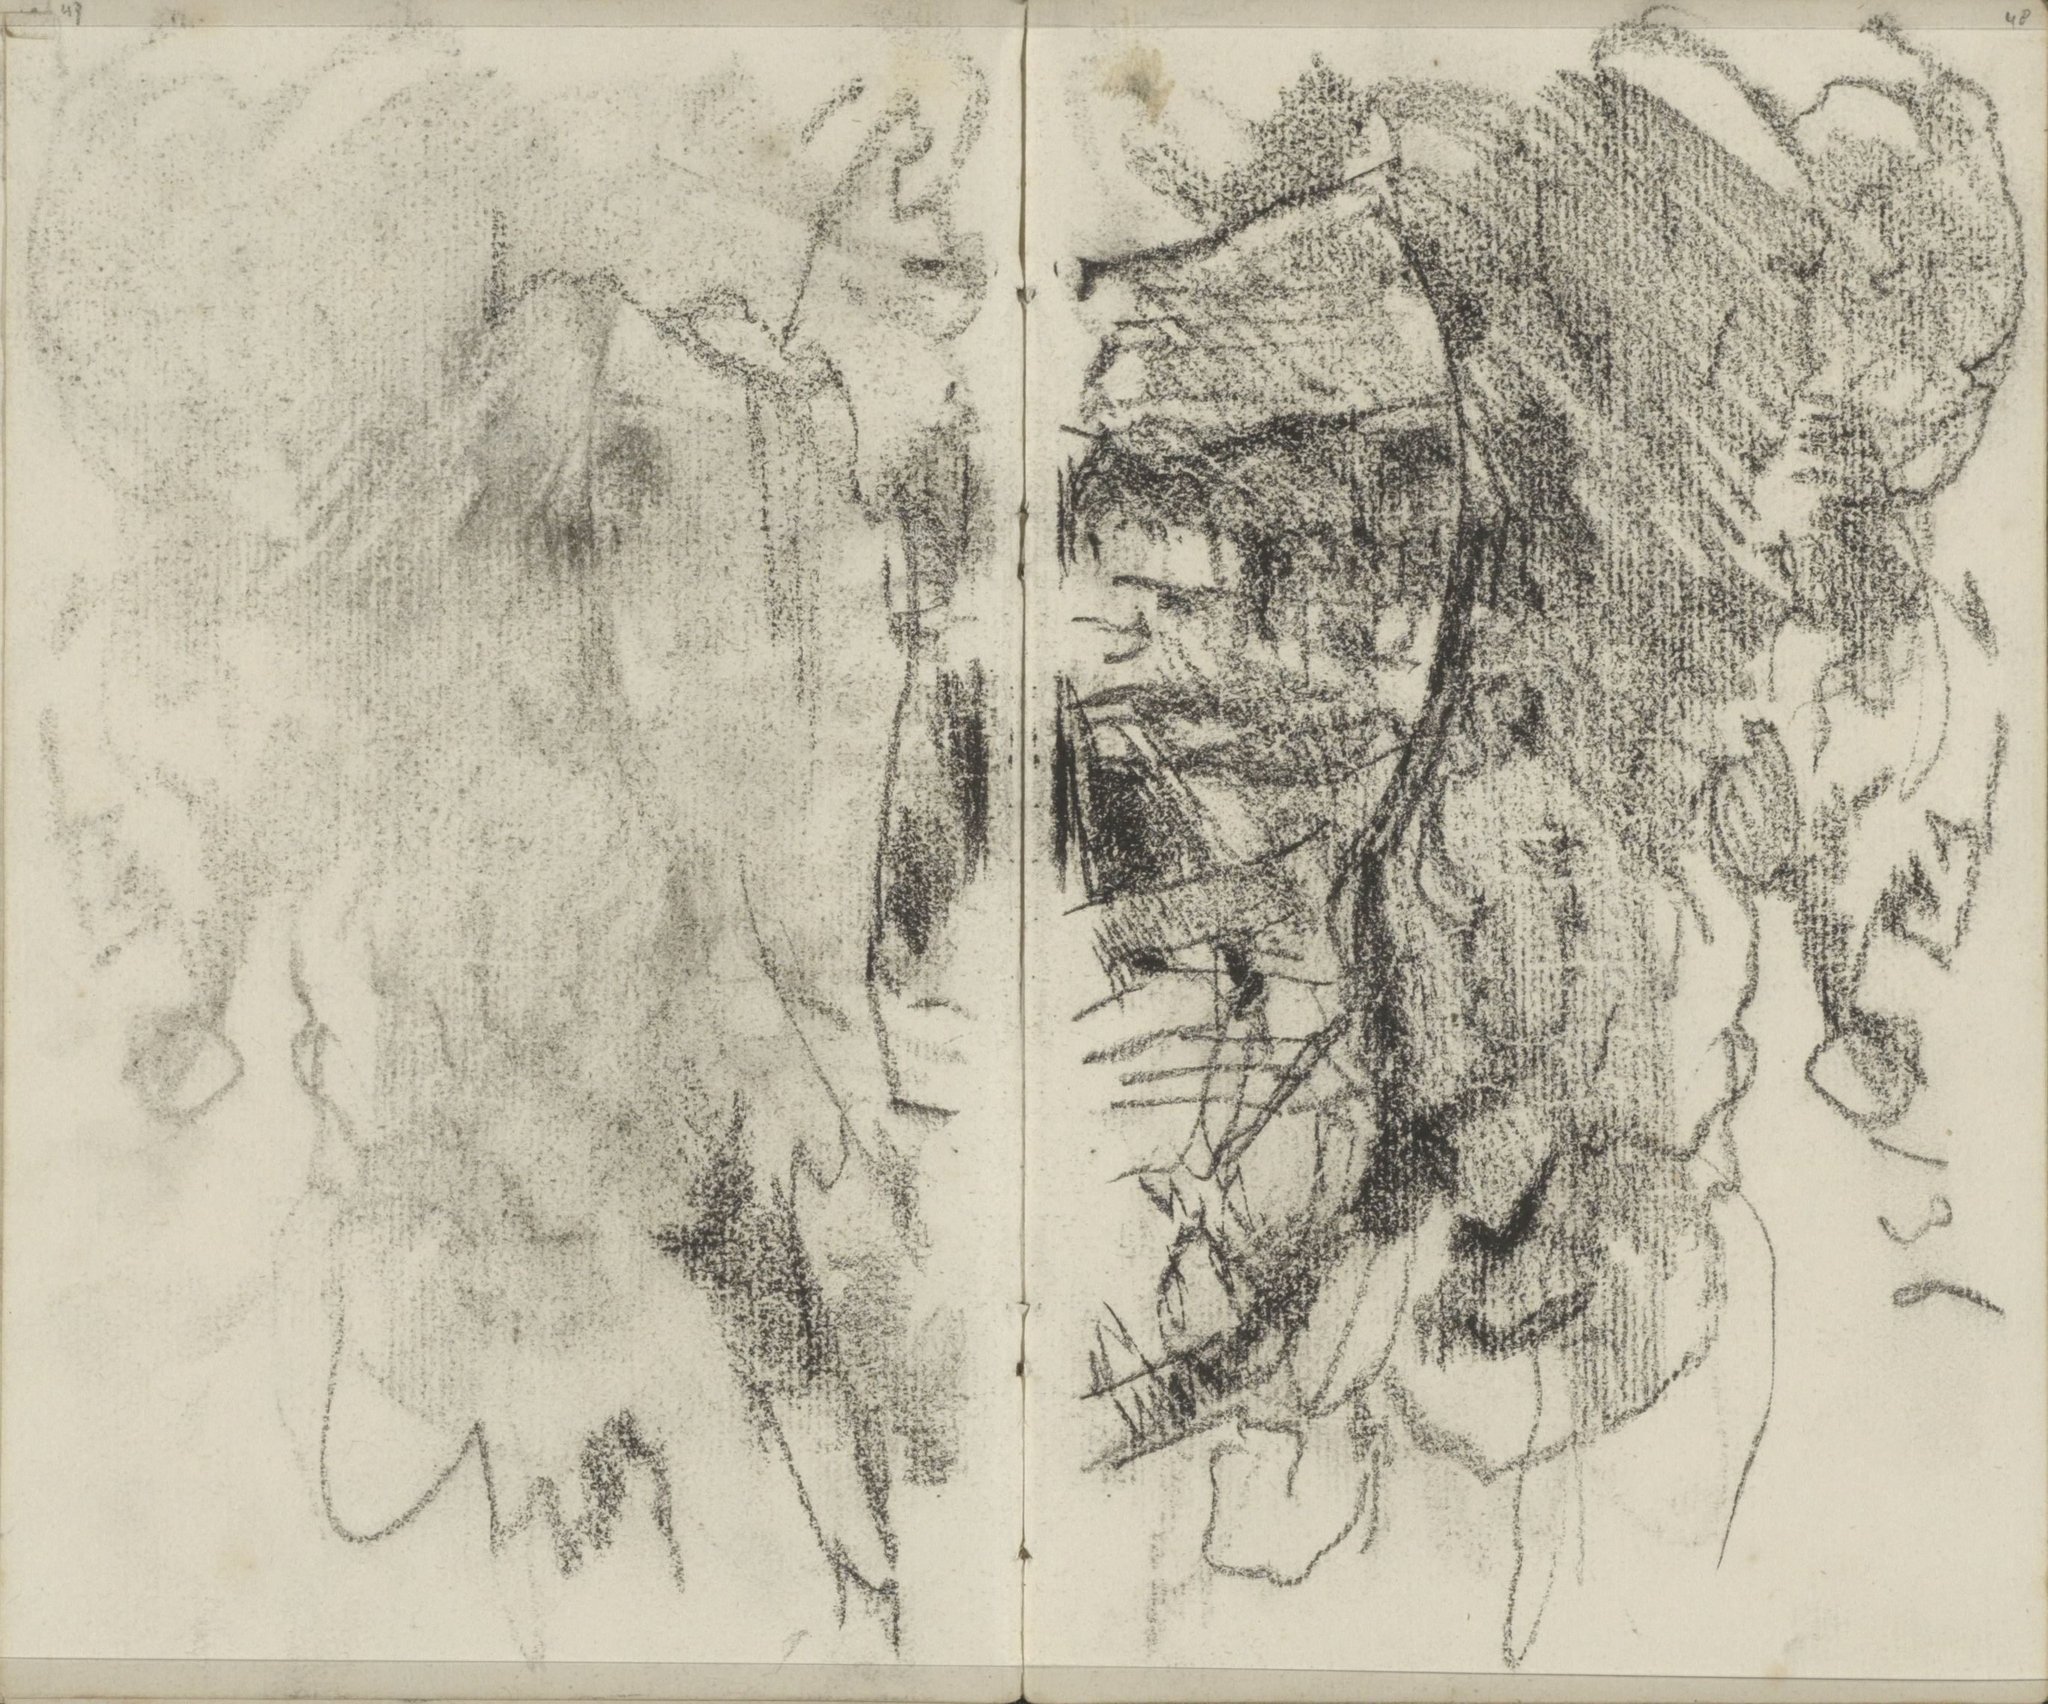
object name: sketchbook leaf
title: Studie, mogelijk van een duinlandschap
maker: george hendrik breitner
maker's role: draughtsman, painter, print maker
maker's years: 1857-1923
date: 1880-1882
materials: chalk, paper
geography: scheveningen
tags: dunes (sea not visible); in the dunes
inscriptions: number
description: Pagina 47 en pagina 48 uit een schetsboek met 31 bladen.